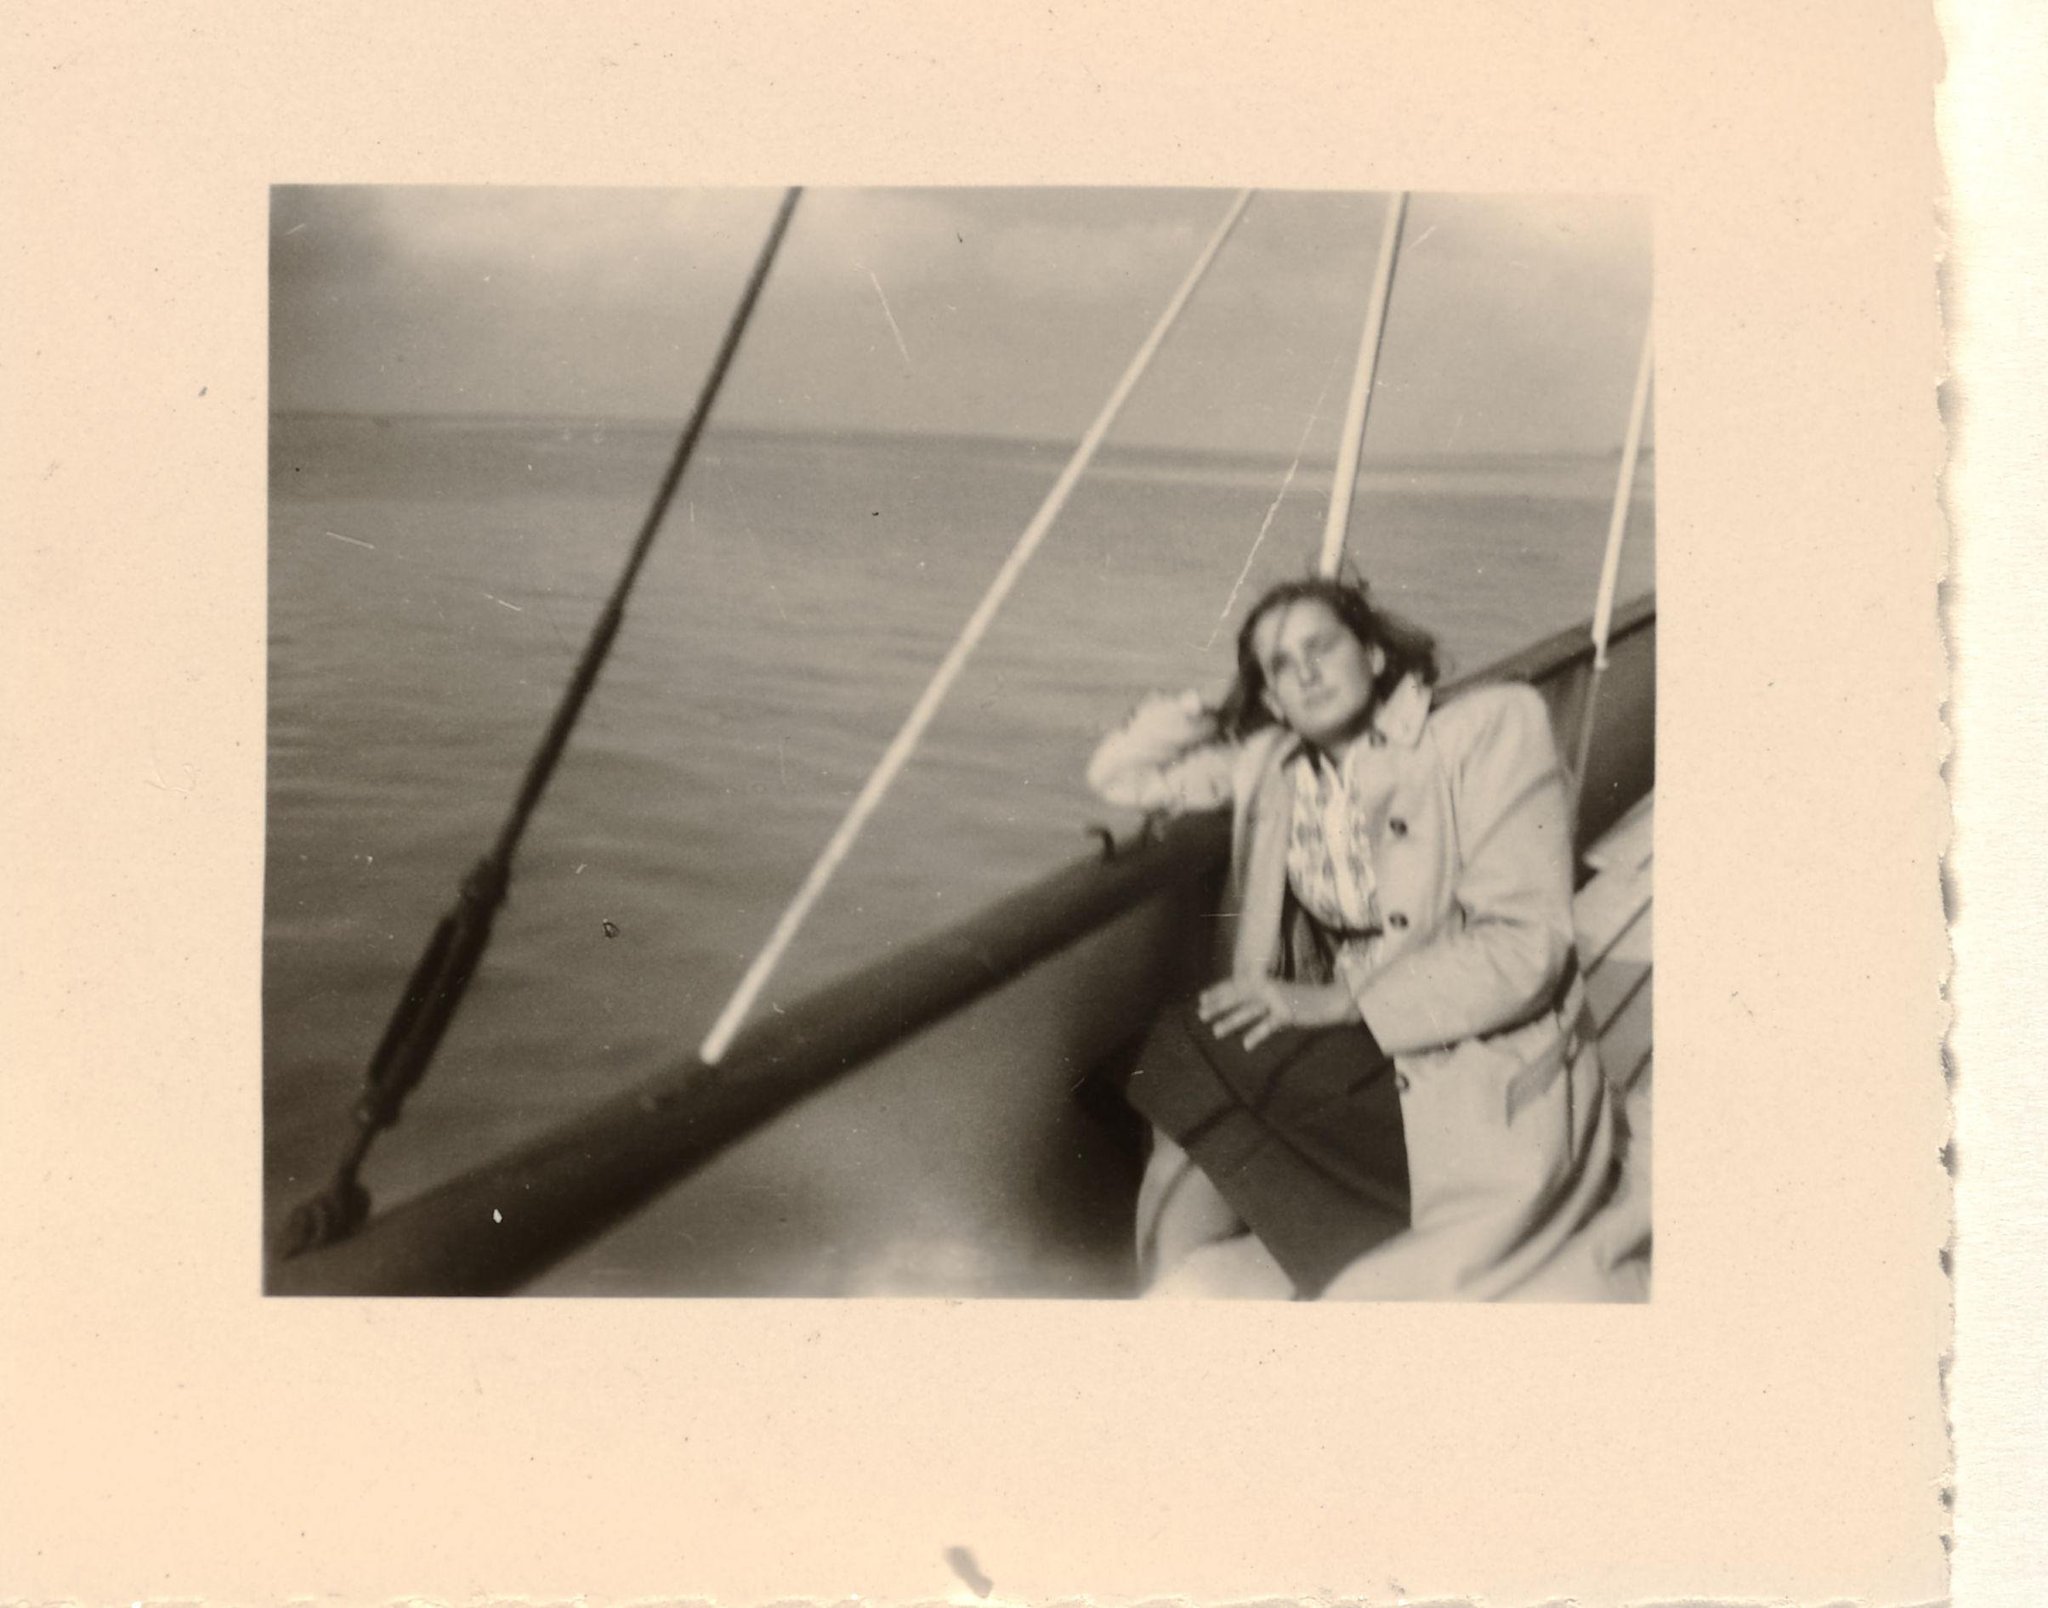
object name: photograph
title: Isabel Wachenheimer op een boot, leunend op de reling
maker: Anonymous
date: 1945-1956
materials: photographic support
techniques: gelatin silver print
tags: isabel wachenheimer-elon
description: Isabel Wachenheimer in lange lichte jas en gezeten op een boot, leunend op de reling.